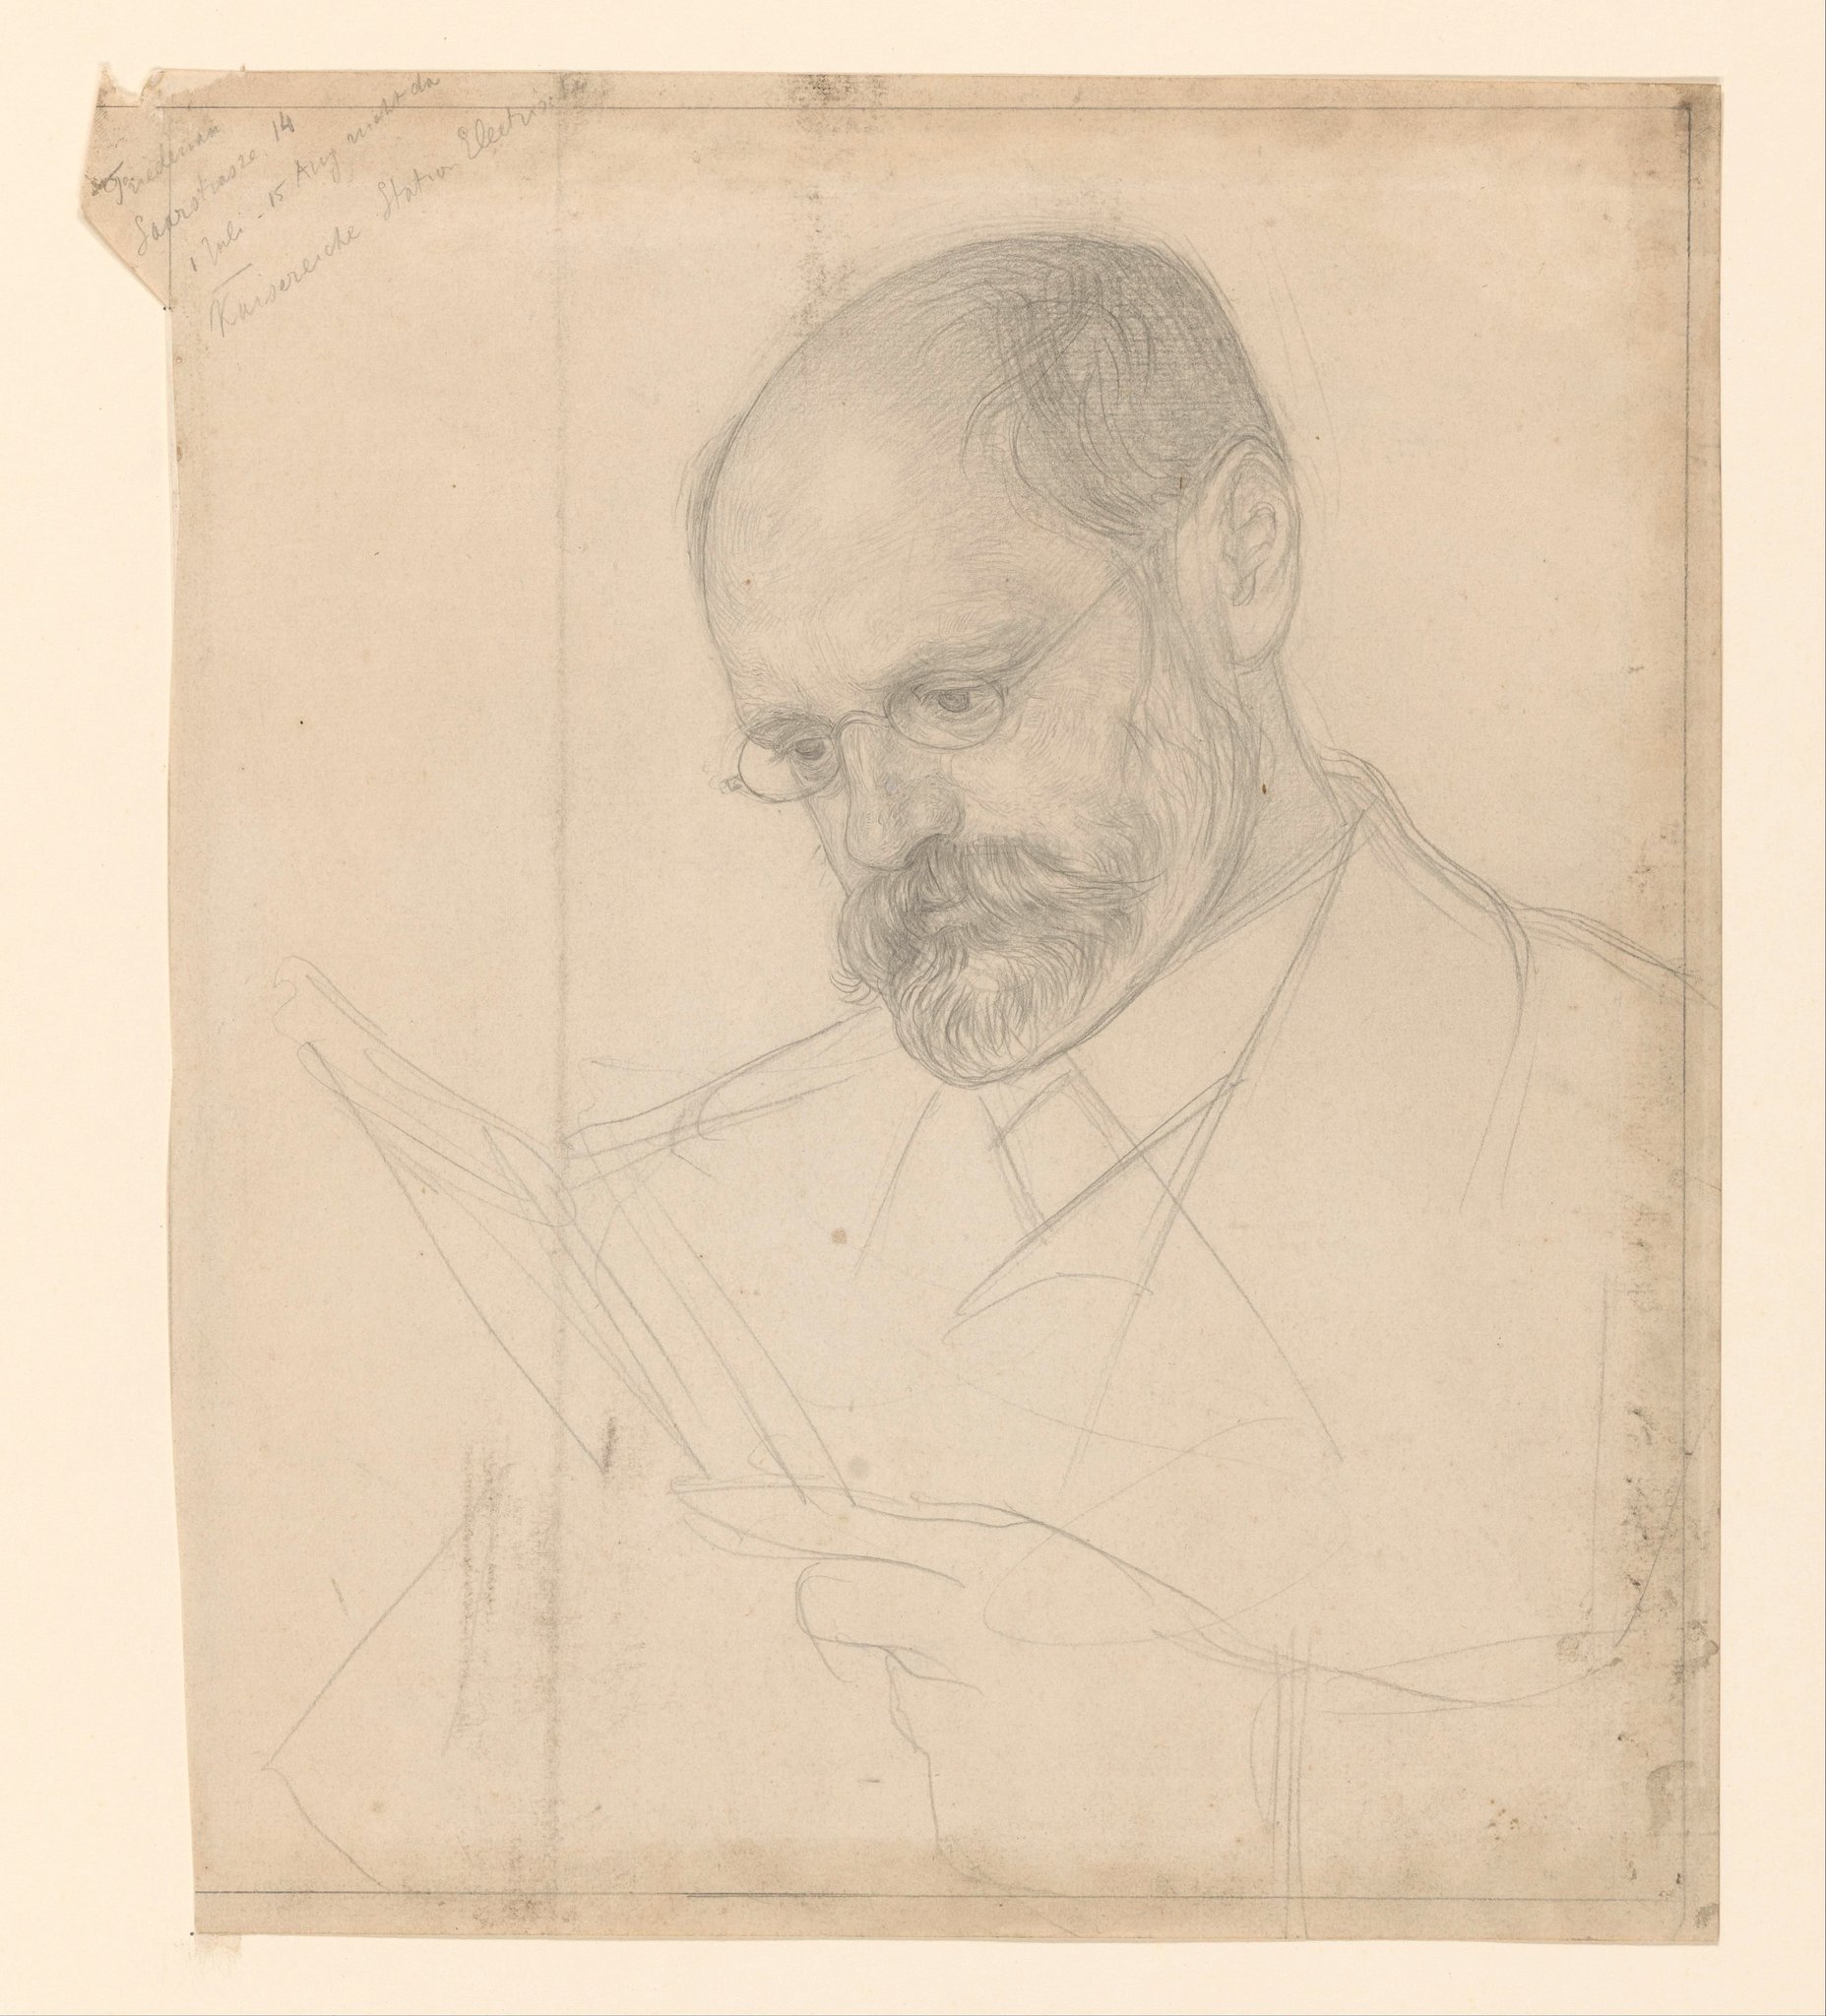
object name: drawing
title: Portret van dhr. K.J. Kautsky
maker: jan veth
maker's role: designer, draughtsman, painter, print maker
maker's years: 1864-1925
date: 1874-1925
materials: paper, pencil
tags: historical persons, portrait of a writer